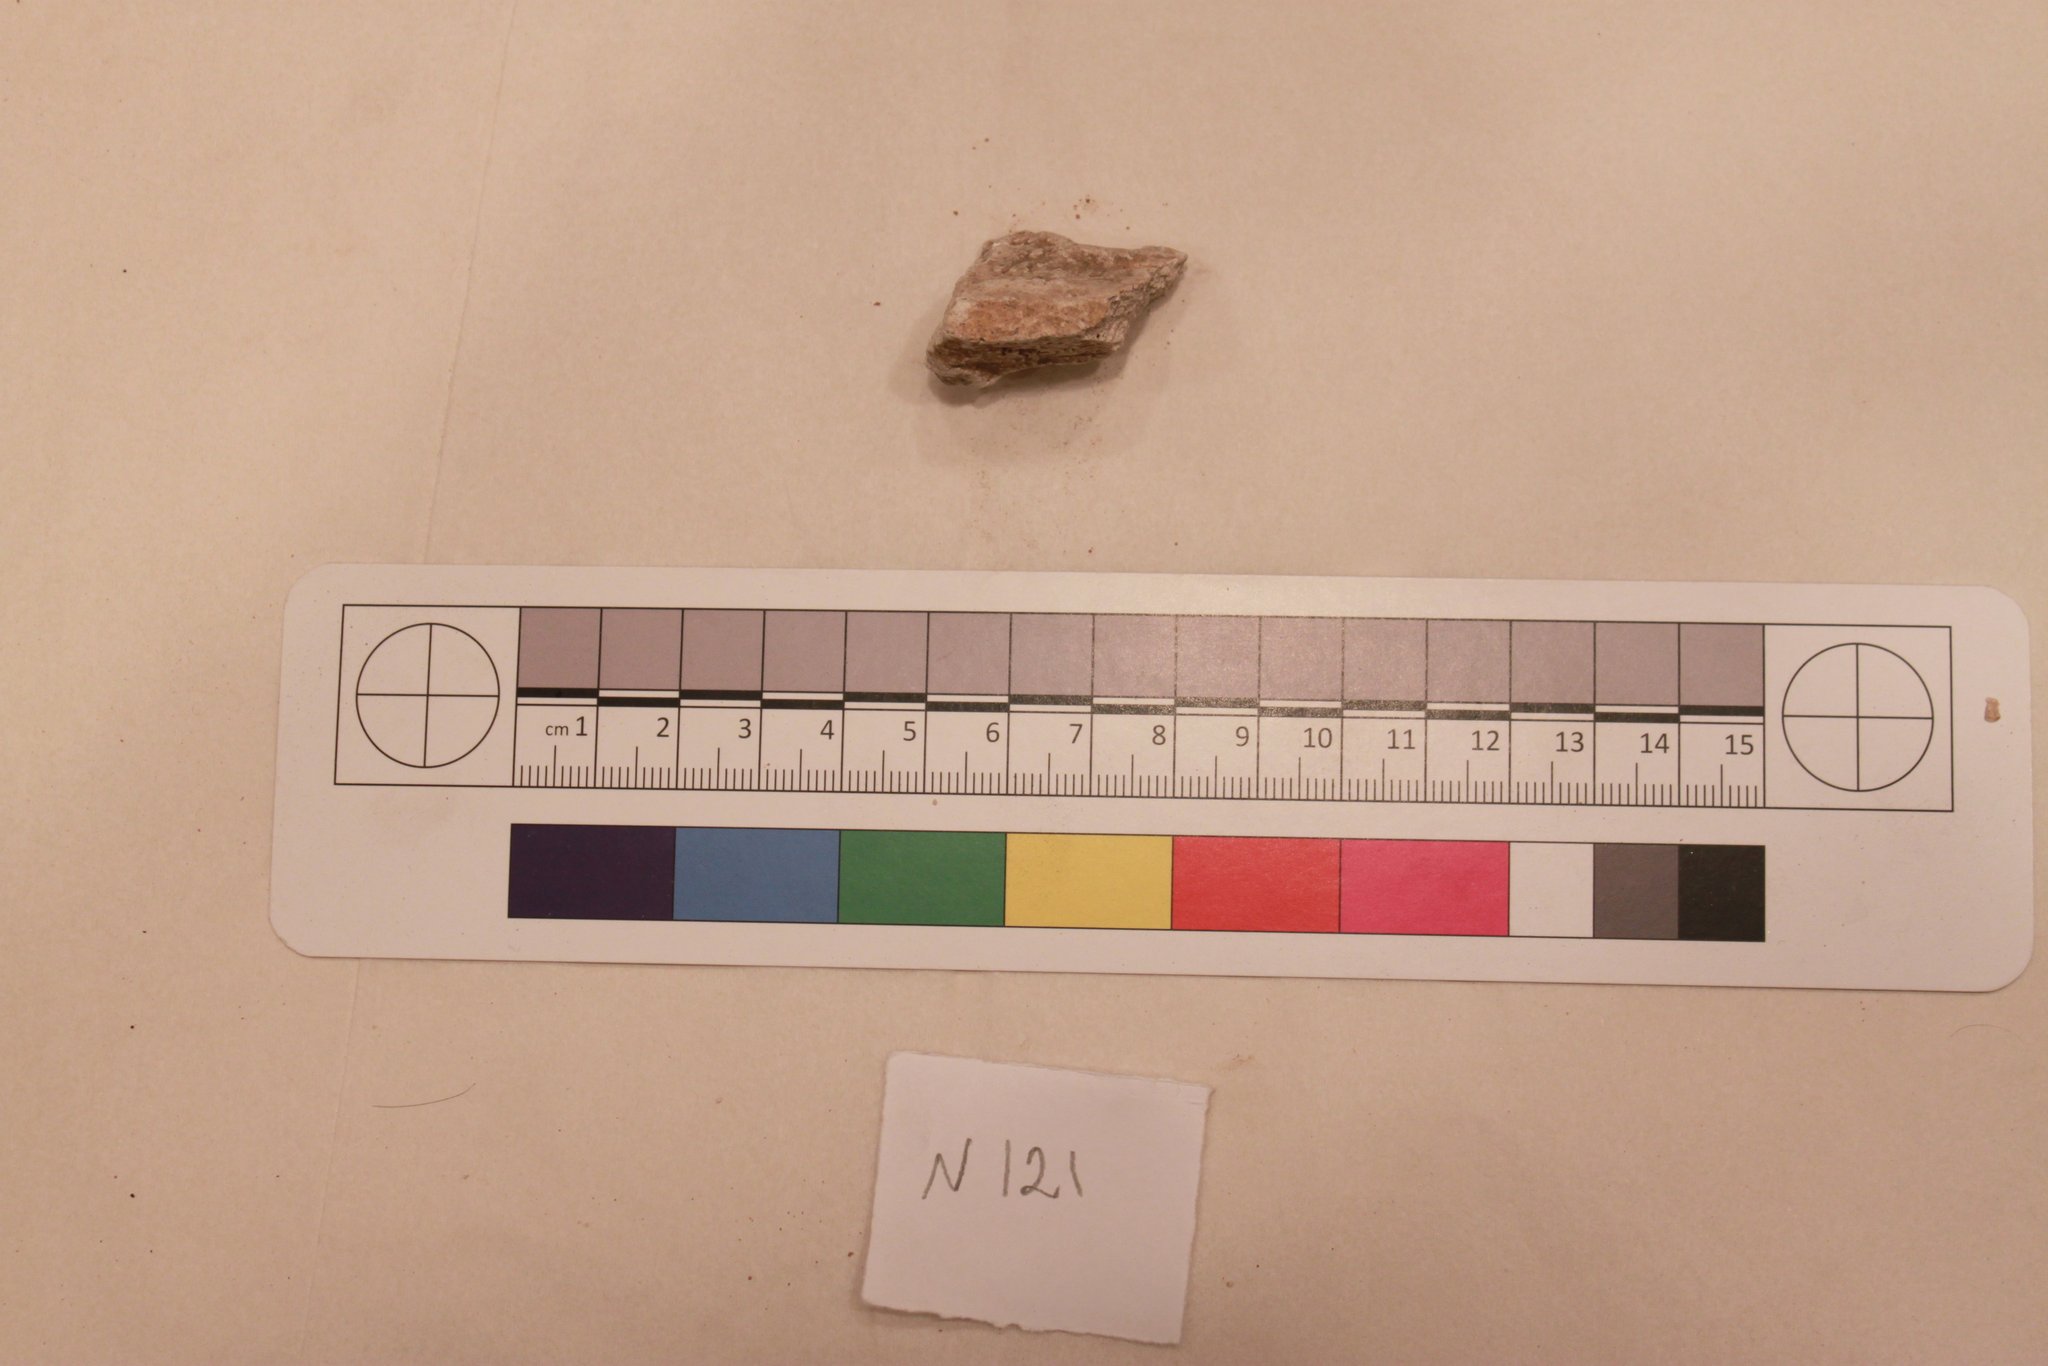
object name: fragment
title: Stucco Fragment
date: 701-1200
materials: plaster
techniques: carving, painting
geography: iran